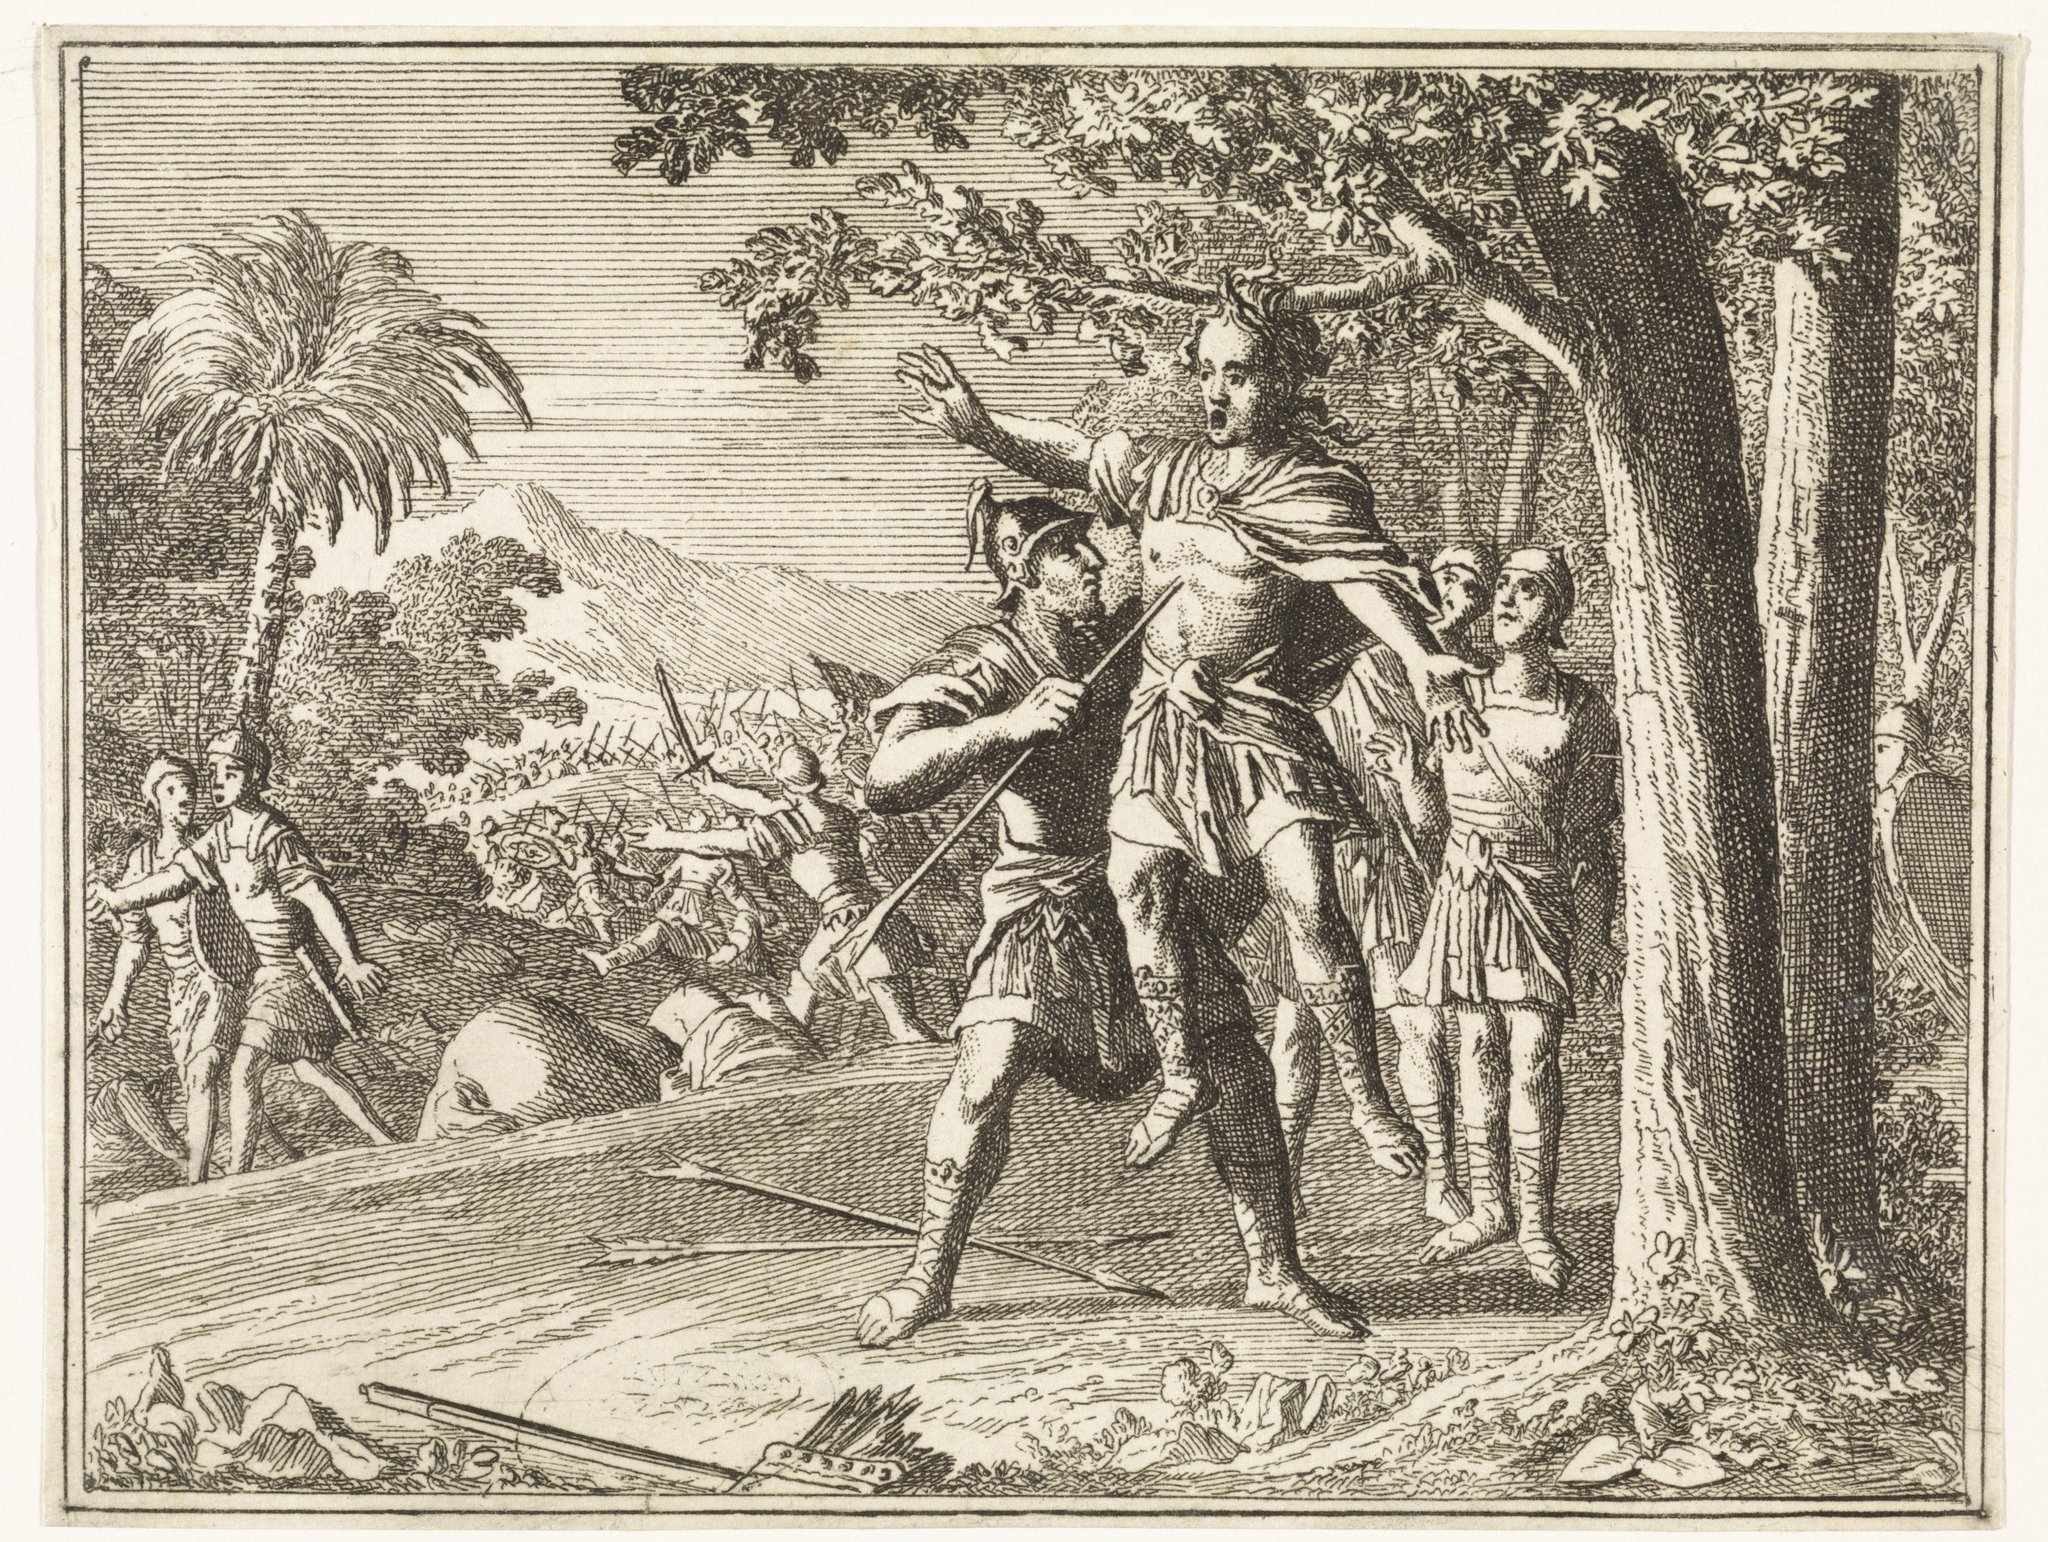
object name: print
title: Absalom door Joab gedood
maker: caspar luyken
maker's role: draughtsman, print maker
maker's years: 1672-1708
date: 1712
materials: paper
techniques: etching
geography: amsterdam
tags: joab stabs absalom with three spears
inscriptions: collector's mark: Lugt 2228, number: ‘117’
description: Illustratie uit: Luyken, Jan. De schriftuurlyke geschiedenissen en gelykenissen van het Oude en Nieuwe Verbond, 2 delen. Amsterdam: Wed. Pieter Arentsz II en Cornelis van der Sys, 1712, dl. I.